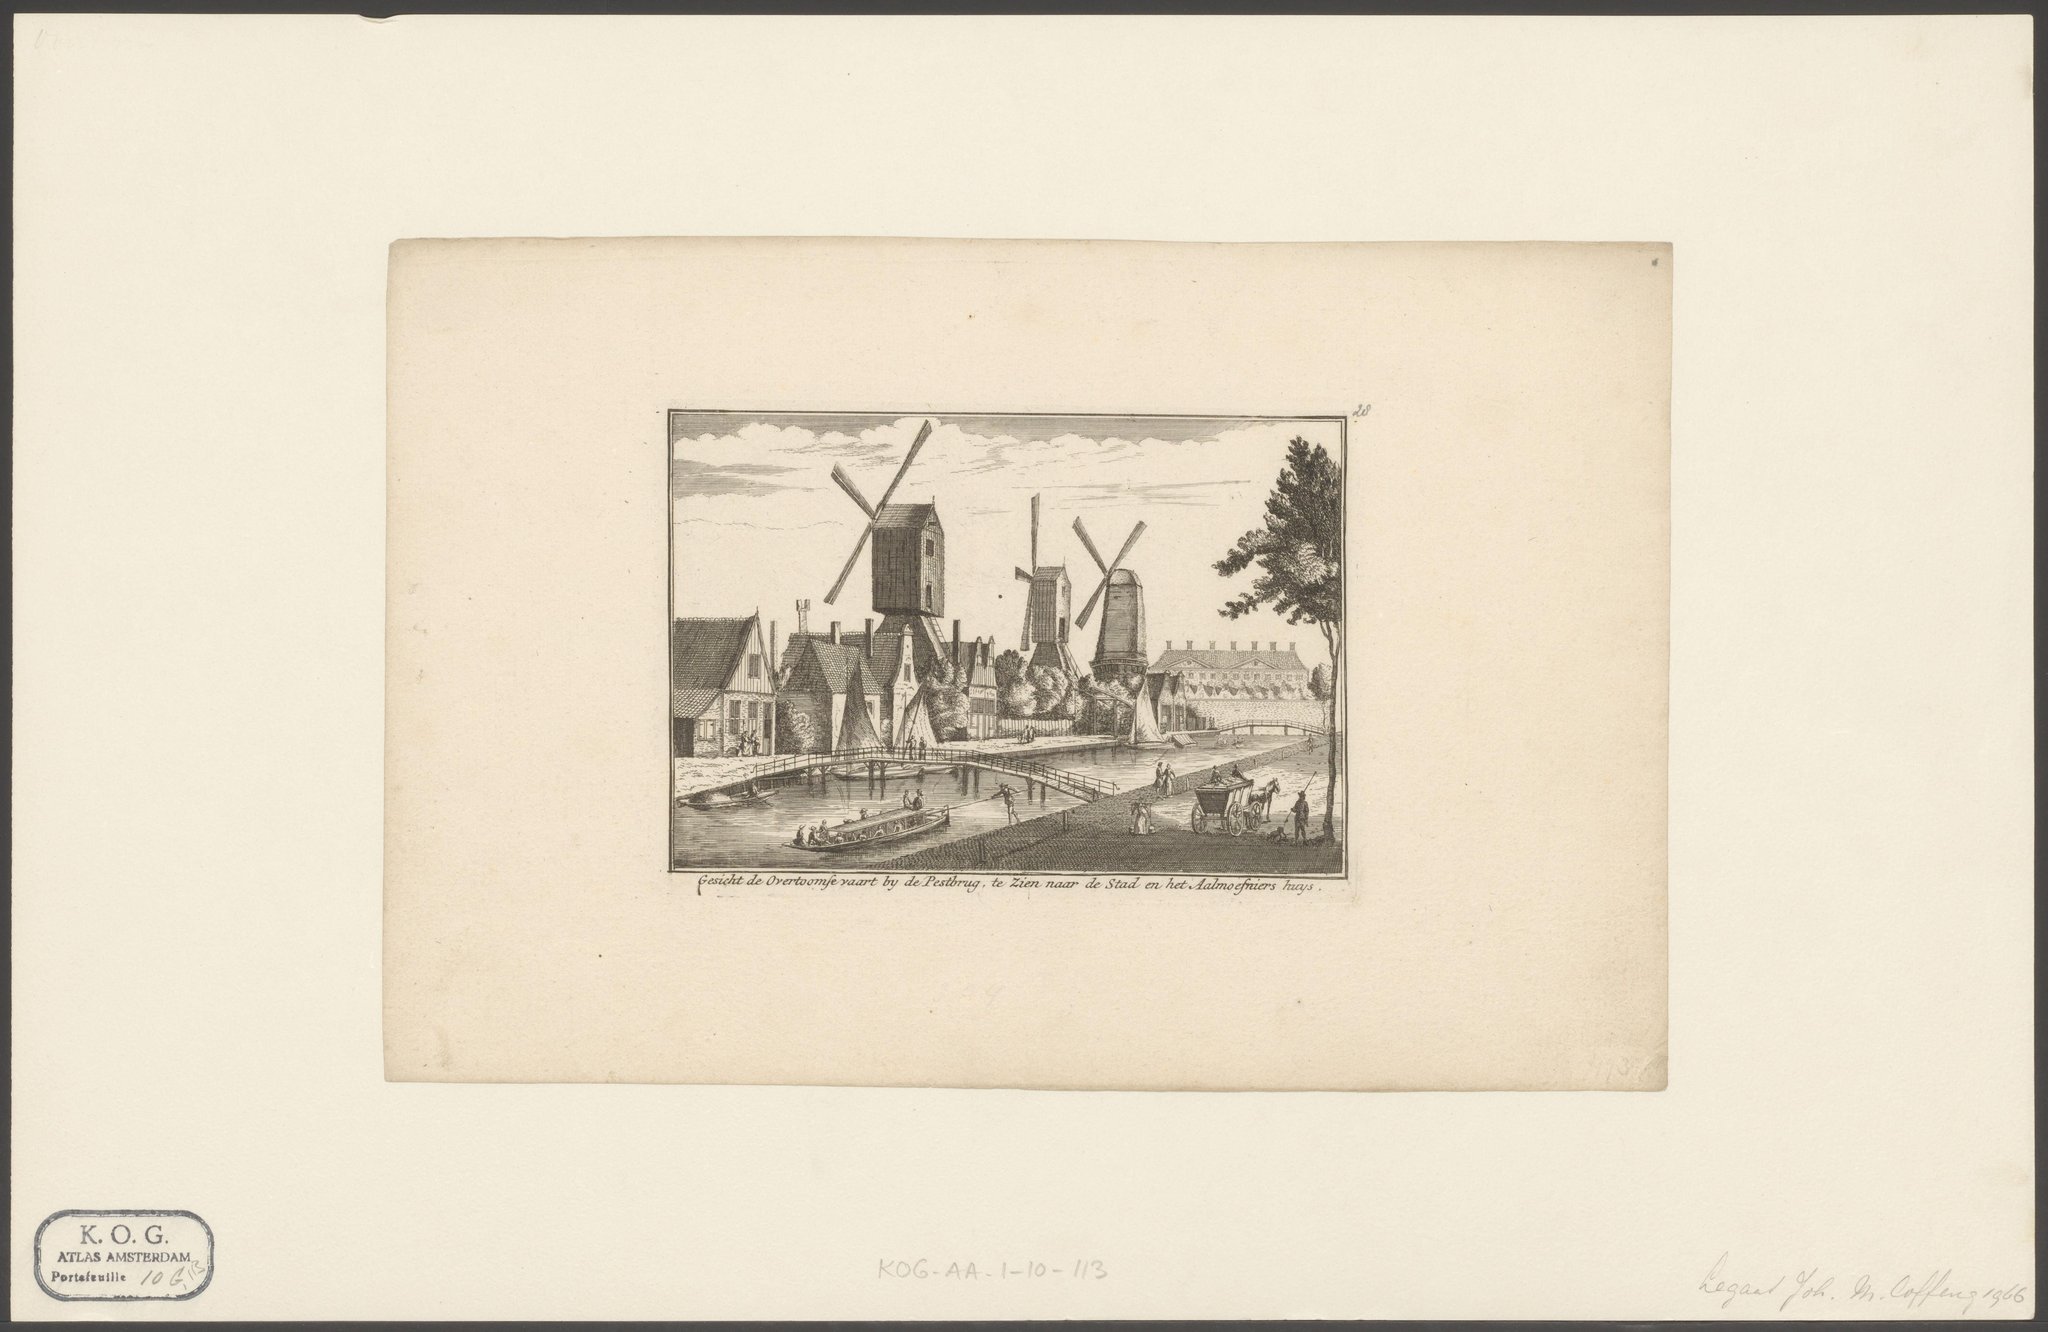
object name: print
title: Gezicht op de Overtoomse vaart bij de Pestbrug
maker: gerardus condet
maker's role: print maker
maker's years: 1715-1764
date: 1725-1764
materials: paper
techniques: etching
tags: city-view in general; 'veduta', river, windmill in landscape, bridge in city across river, canal, etc., boat propelled by man or animal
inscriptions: inscription: ‘Legaat Joh. M. Coffeng. 1966’, collector's mark: ‘10G,113’ Lugt 1641b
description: Onderwerpsrubriek binnen de Atlas Amsterdam: Overtoom.